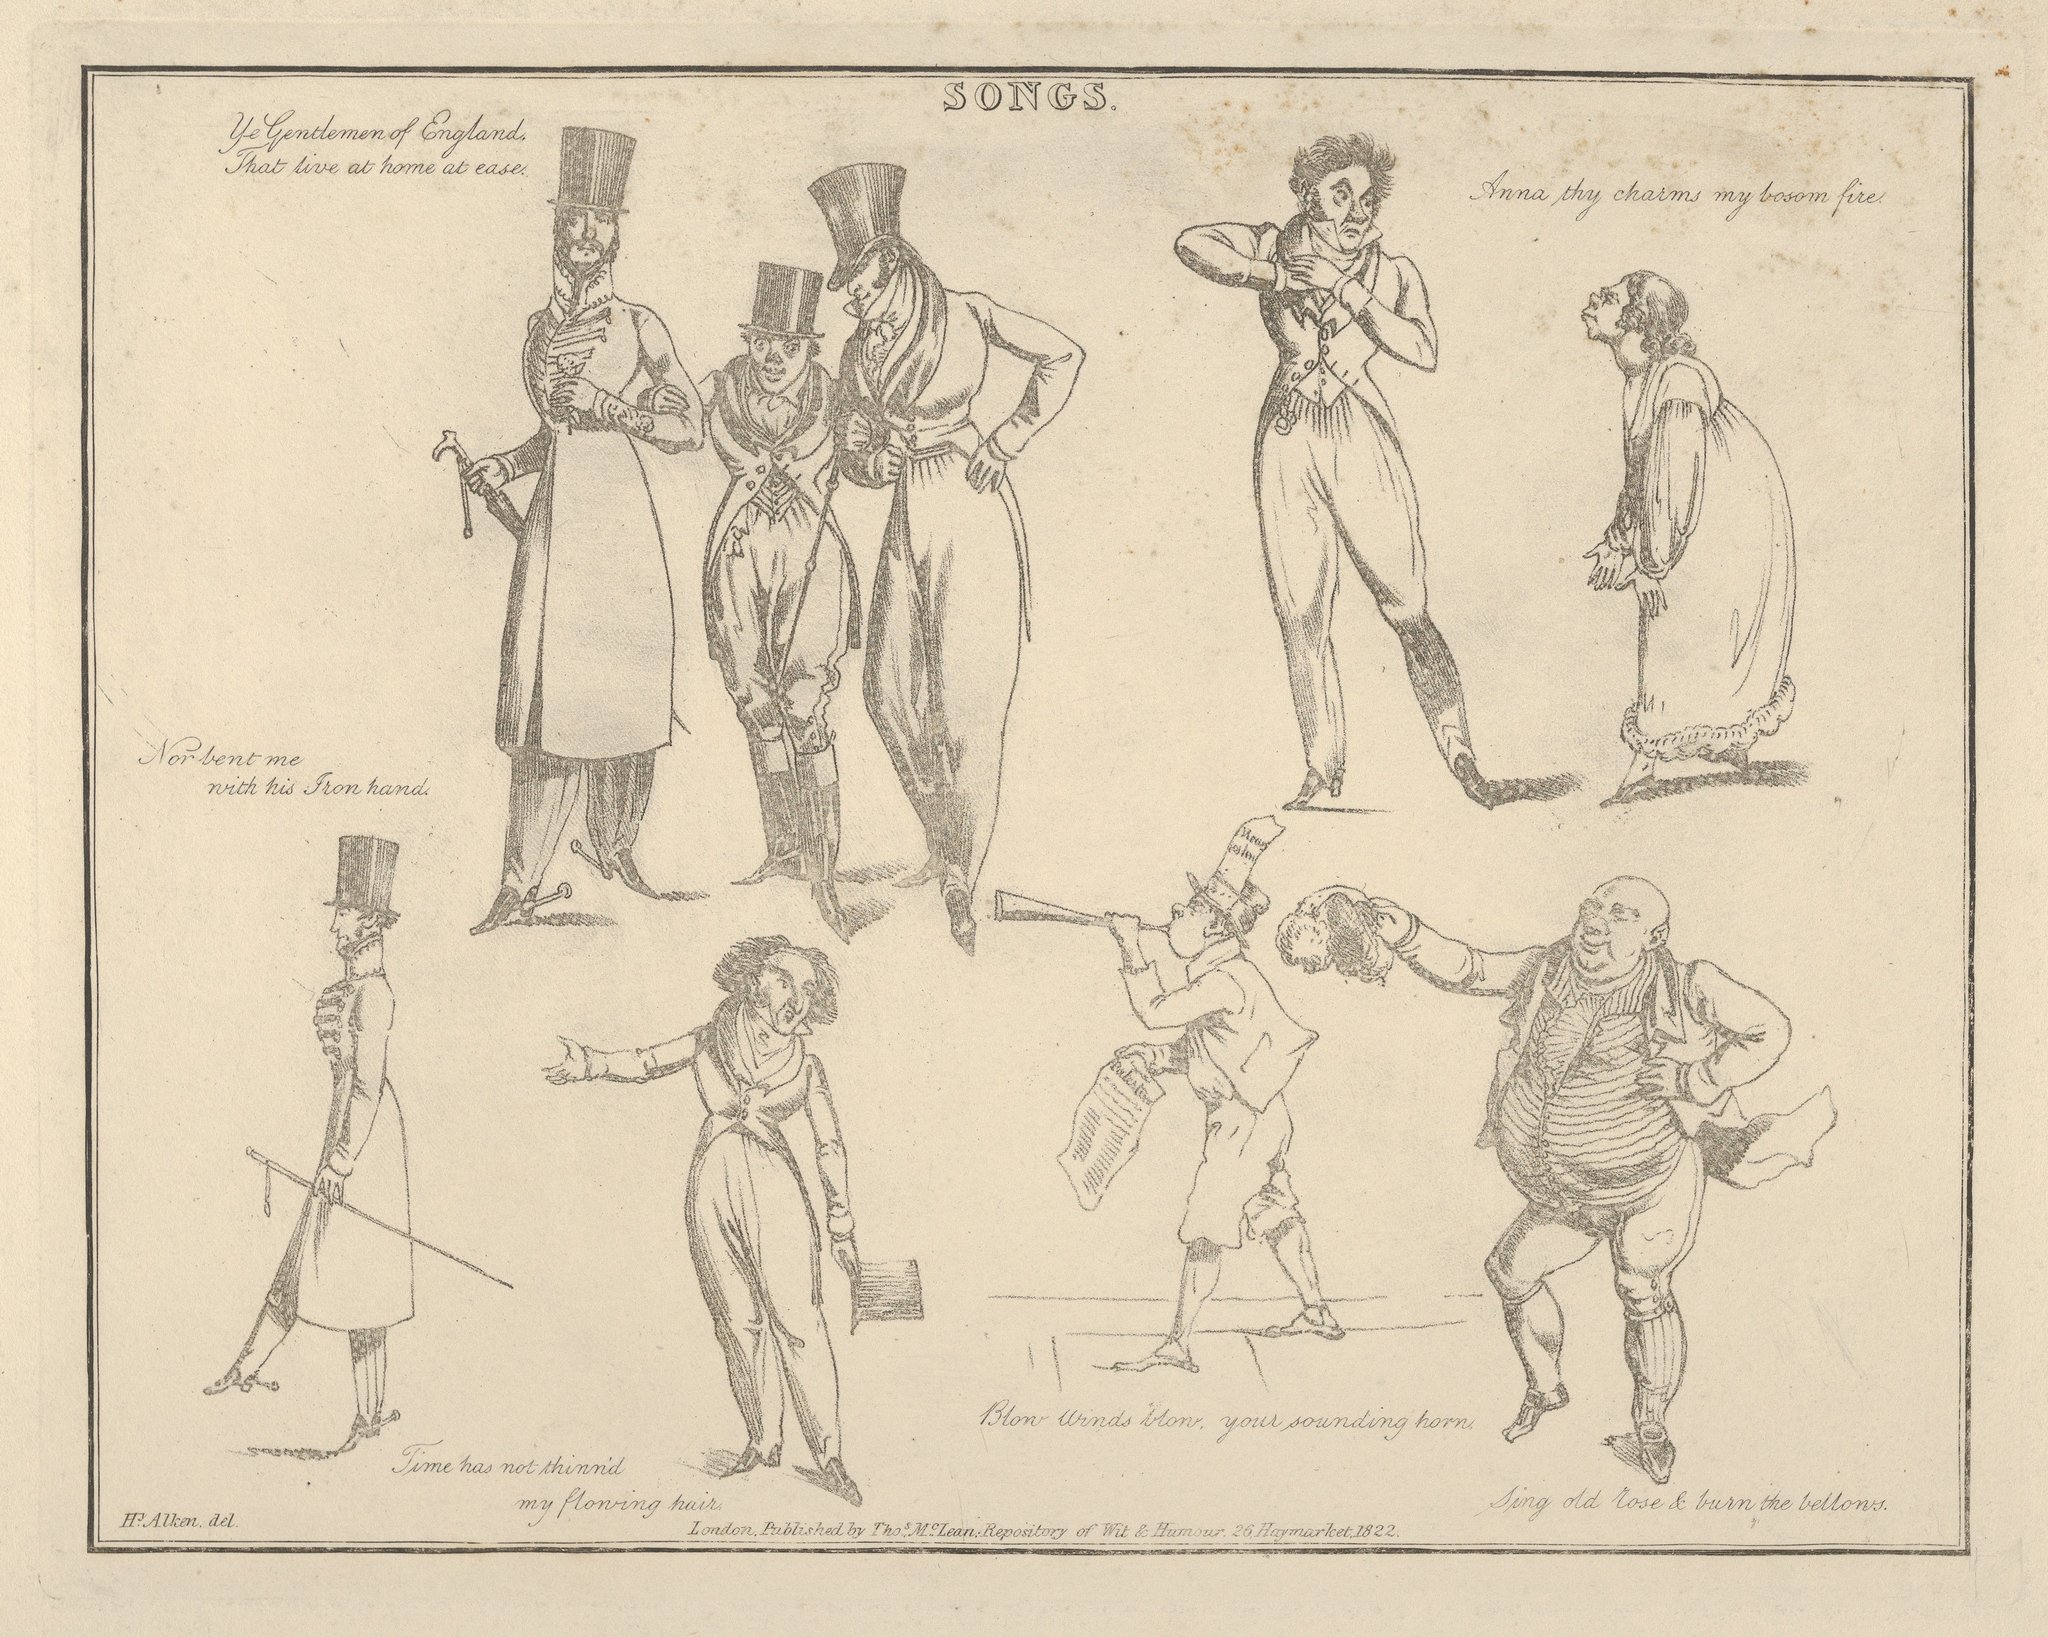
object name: print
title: Songs: "Ye Gentlemen of England That Live at Ease..."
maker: henry alken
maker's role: artist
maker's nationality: british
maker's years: 1785-1851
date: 1822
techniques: etching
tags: men,women,horns